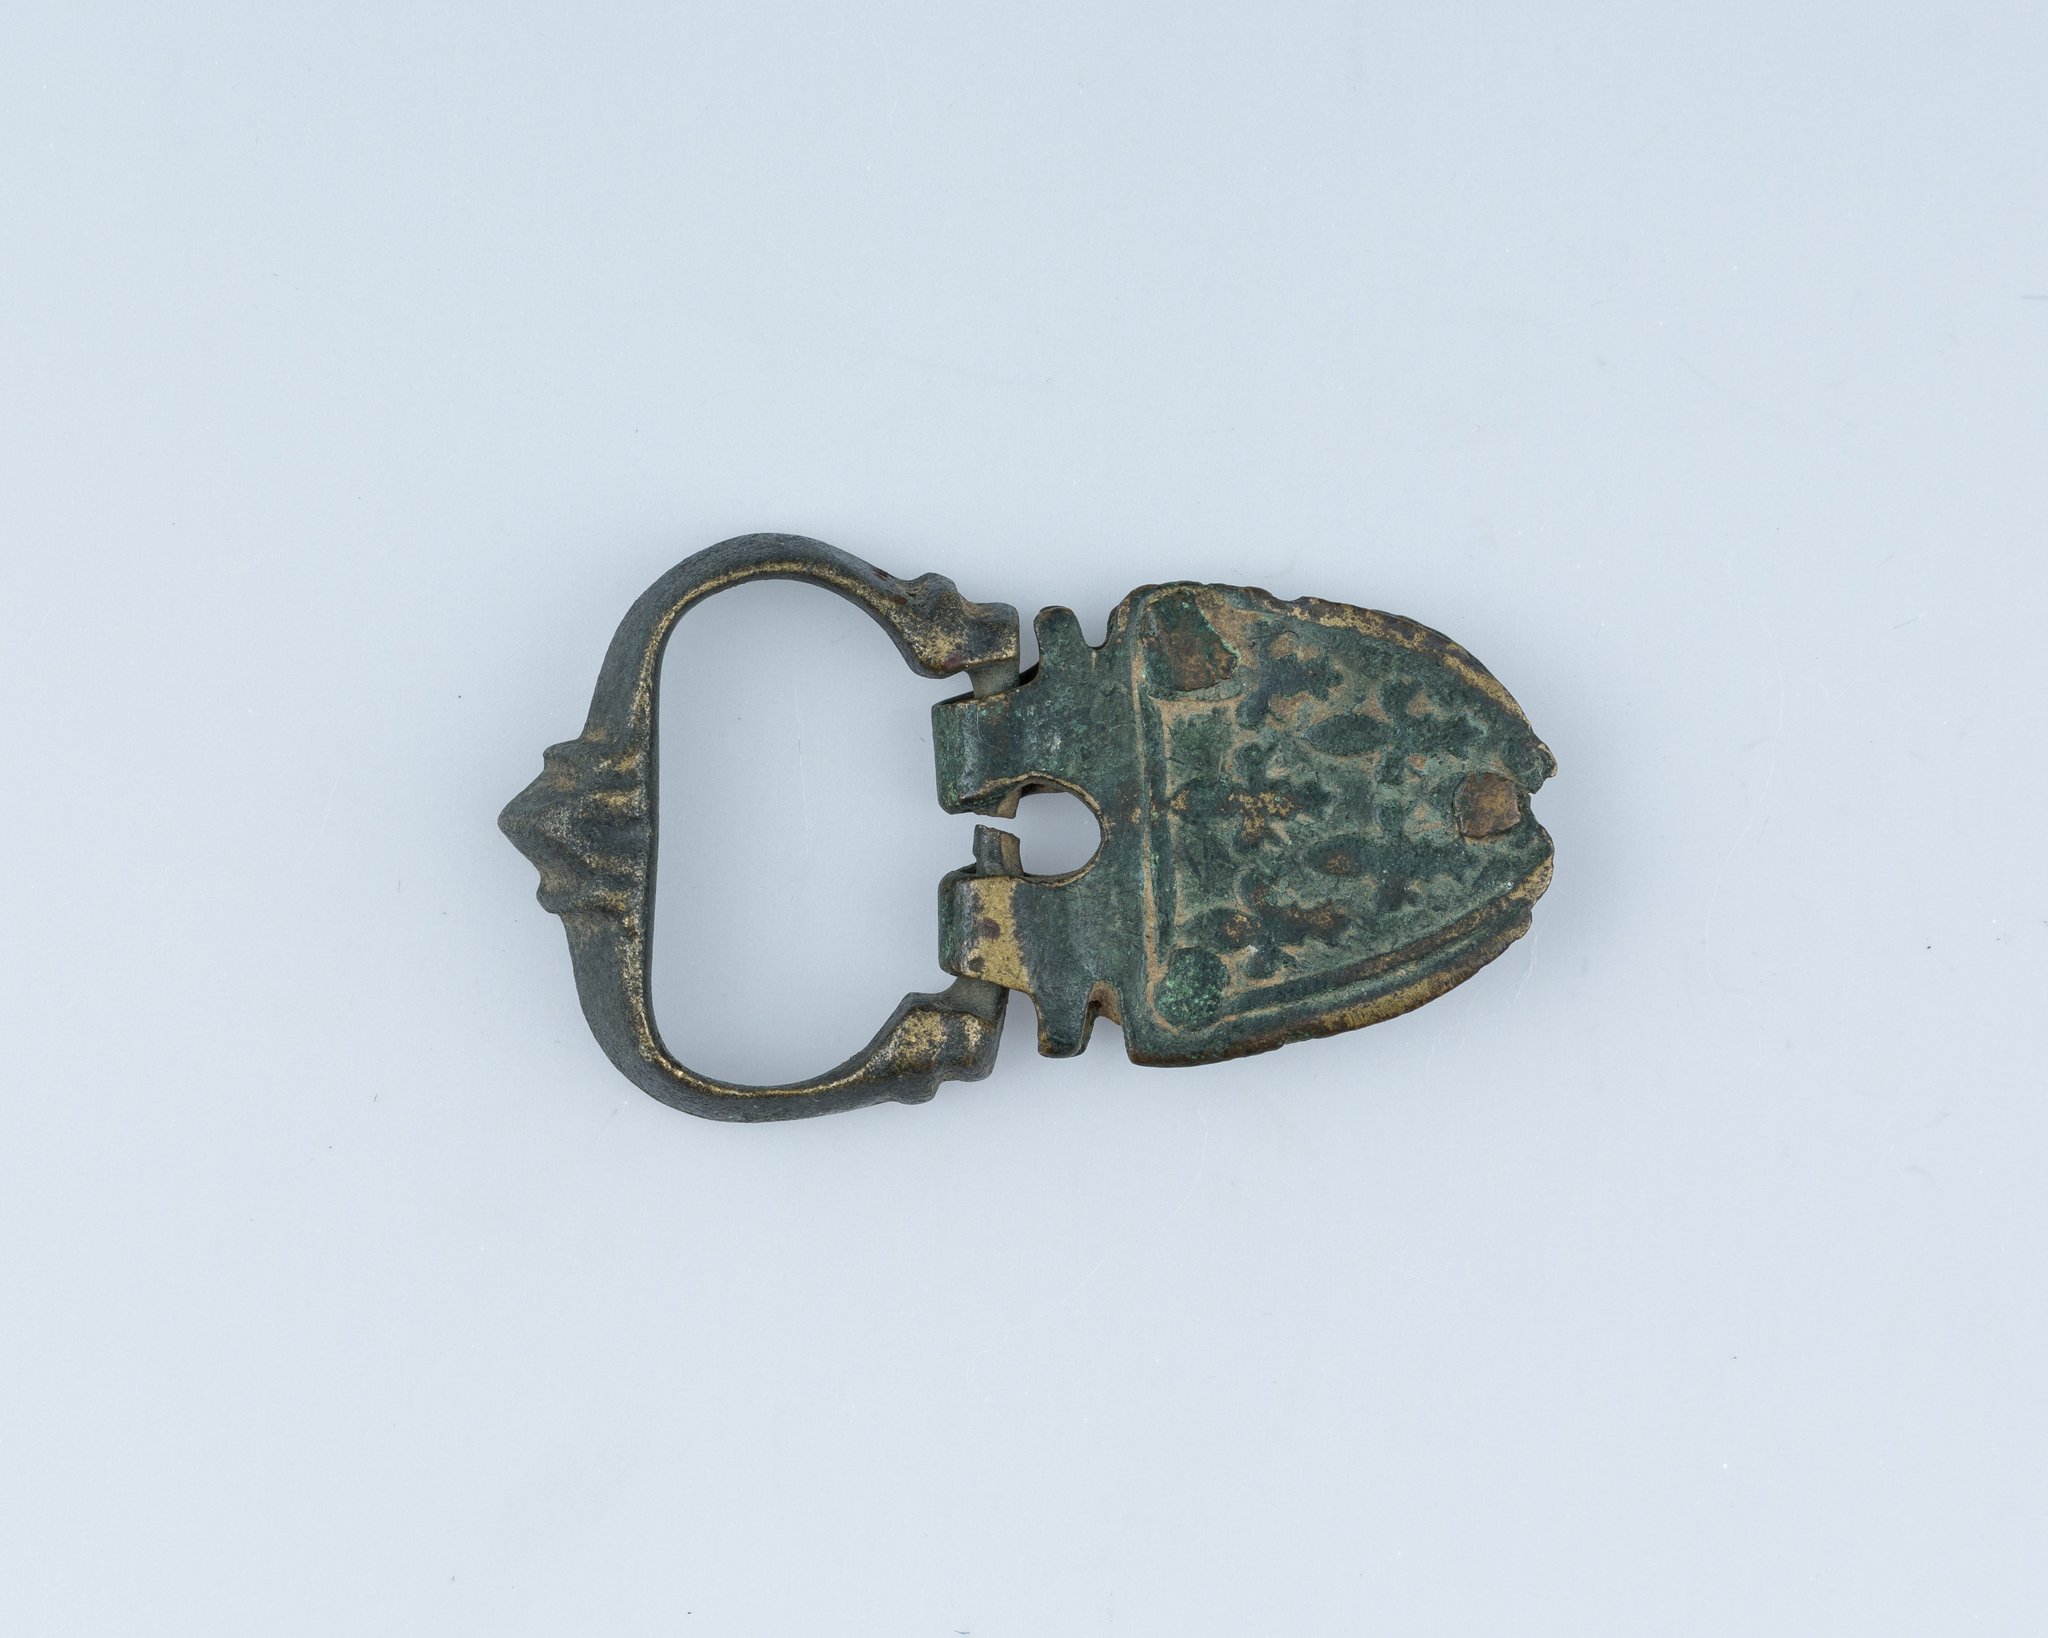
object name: buckle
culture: french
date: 1401-1500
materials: bronze, patina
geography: france